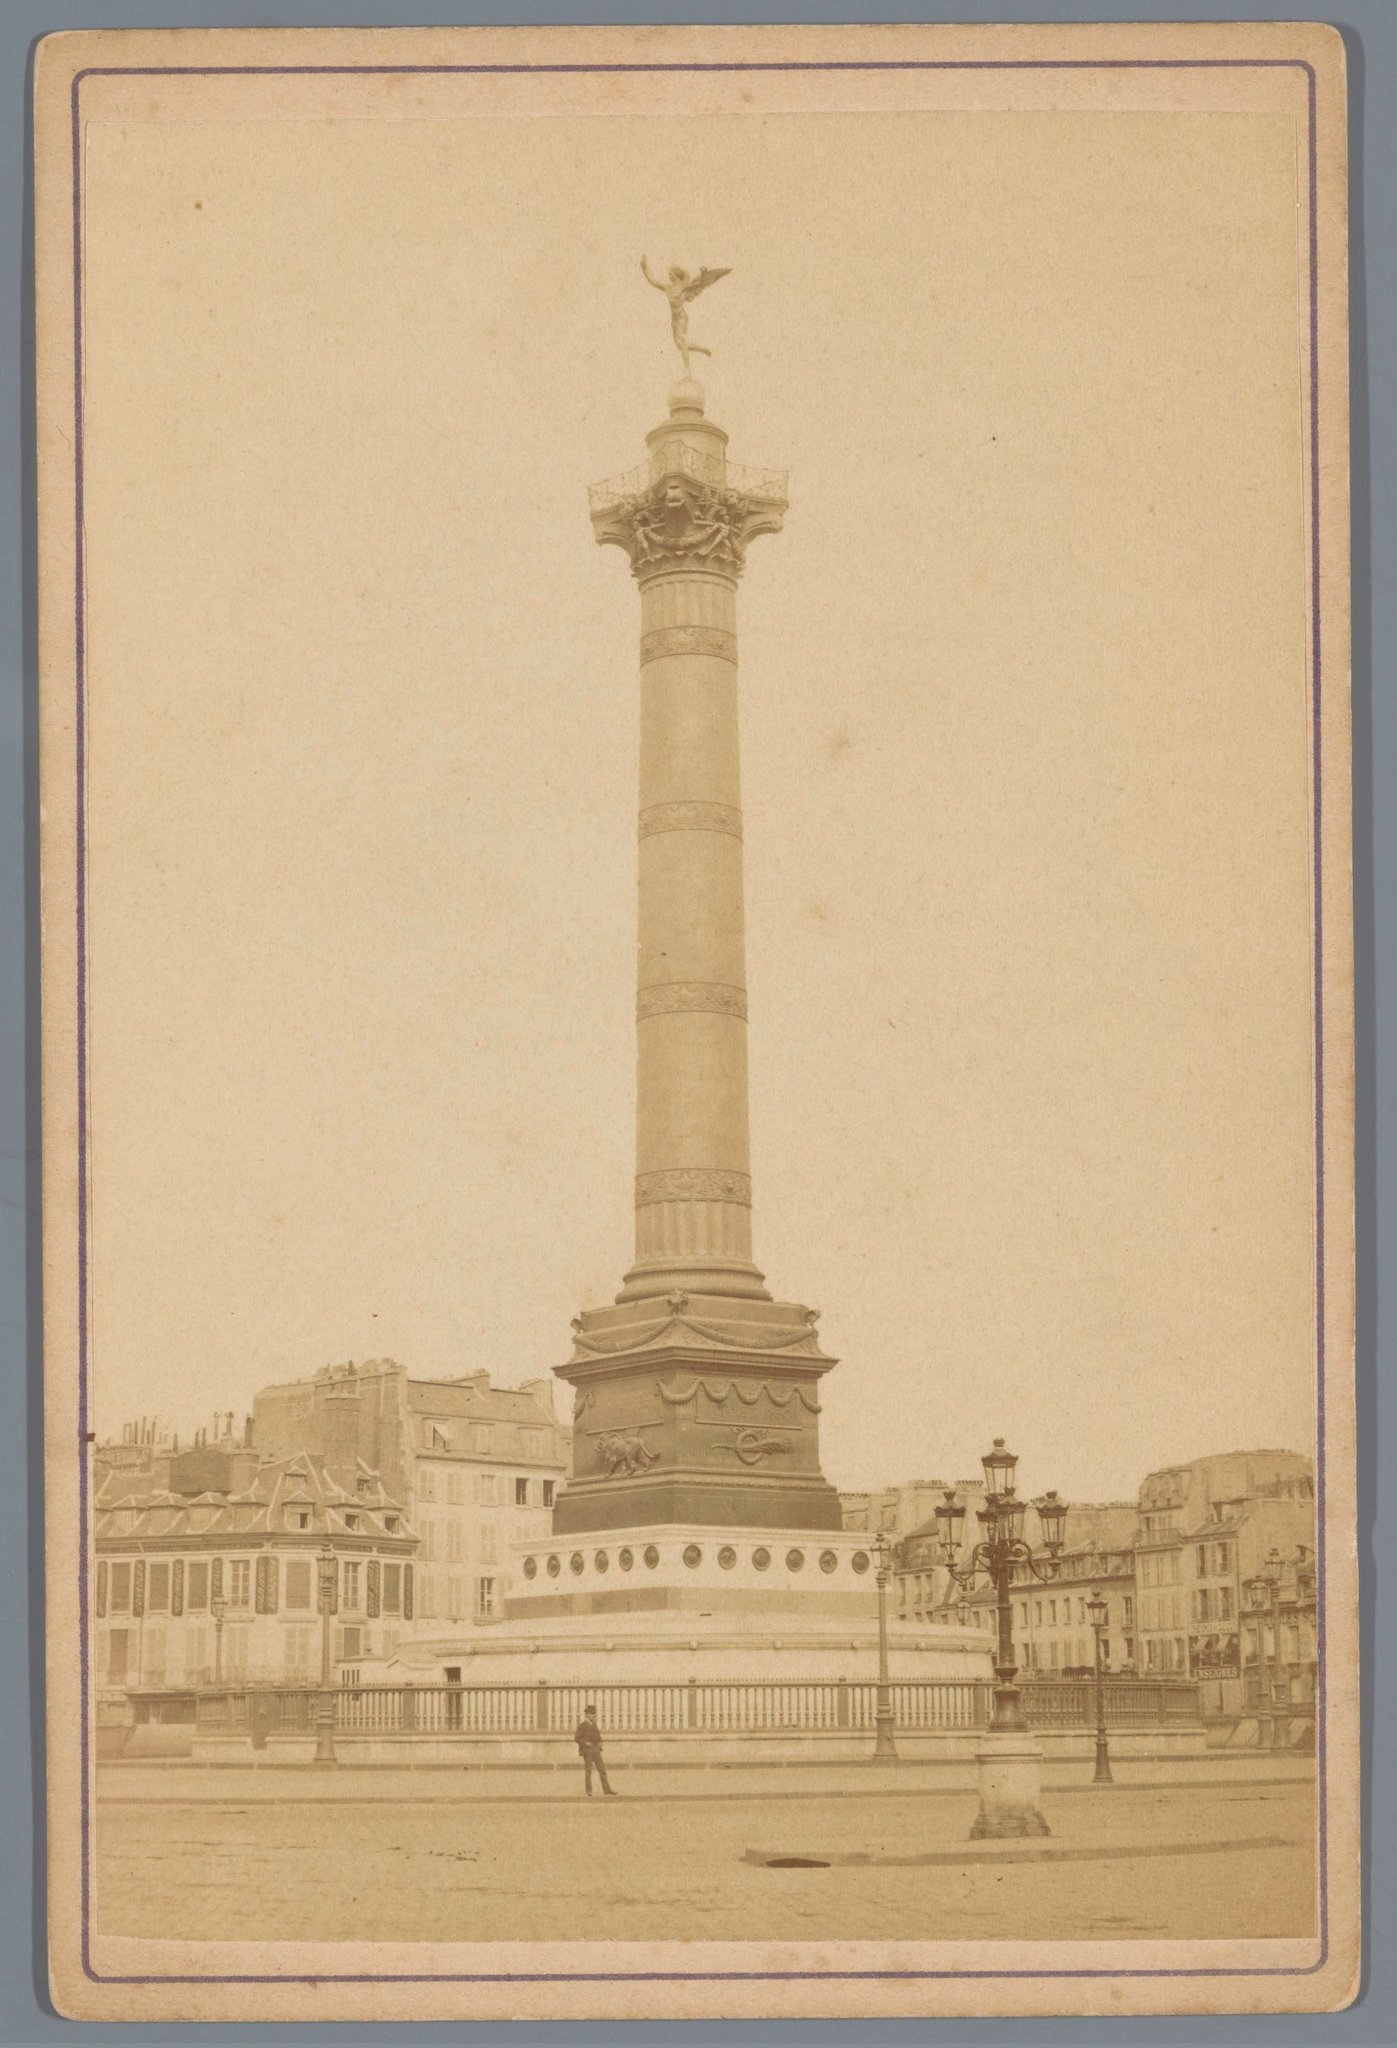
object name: cabinet photograph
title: Colonne de Juillet op de Place de la Bastille te Parijs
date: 1865-1875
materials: cardboard, photographic support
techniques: albumen print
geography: place de la bastille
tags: column, pillar ~ architecture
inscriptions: inscription: ‘Compagnie Photographique Debitte & Hervé 170, Rue de Rivoli, Paris’, inscription: ‘Colonne de Juilliet Place de la Bastille’